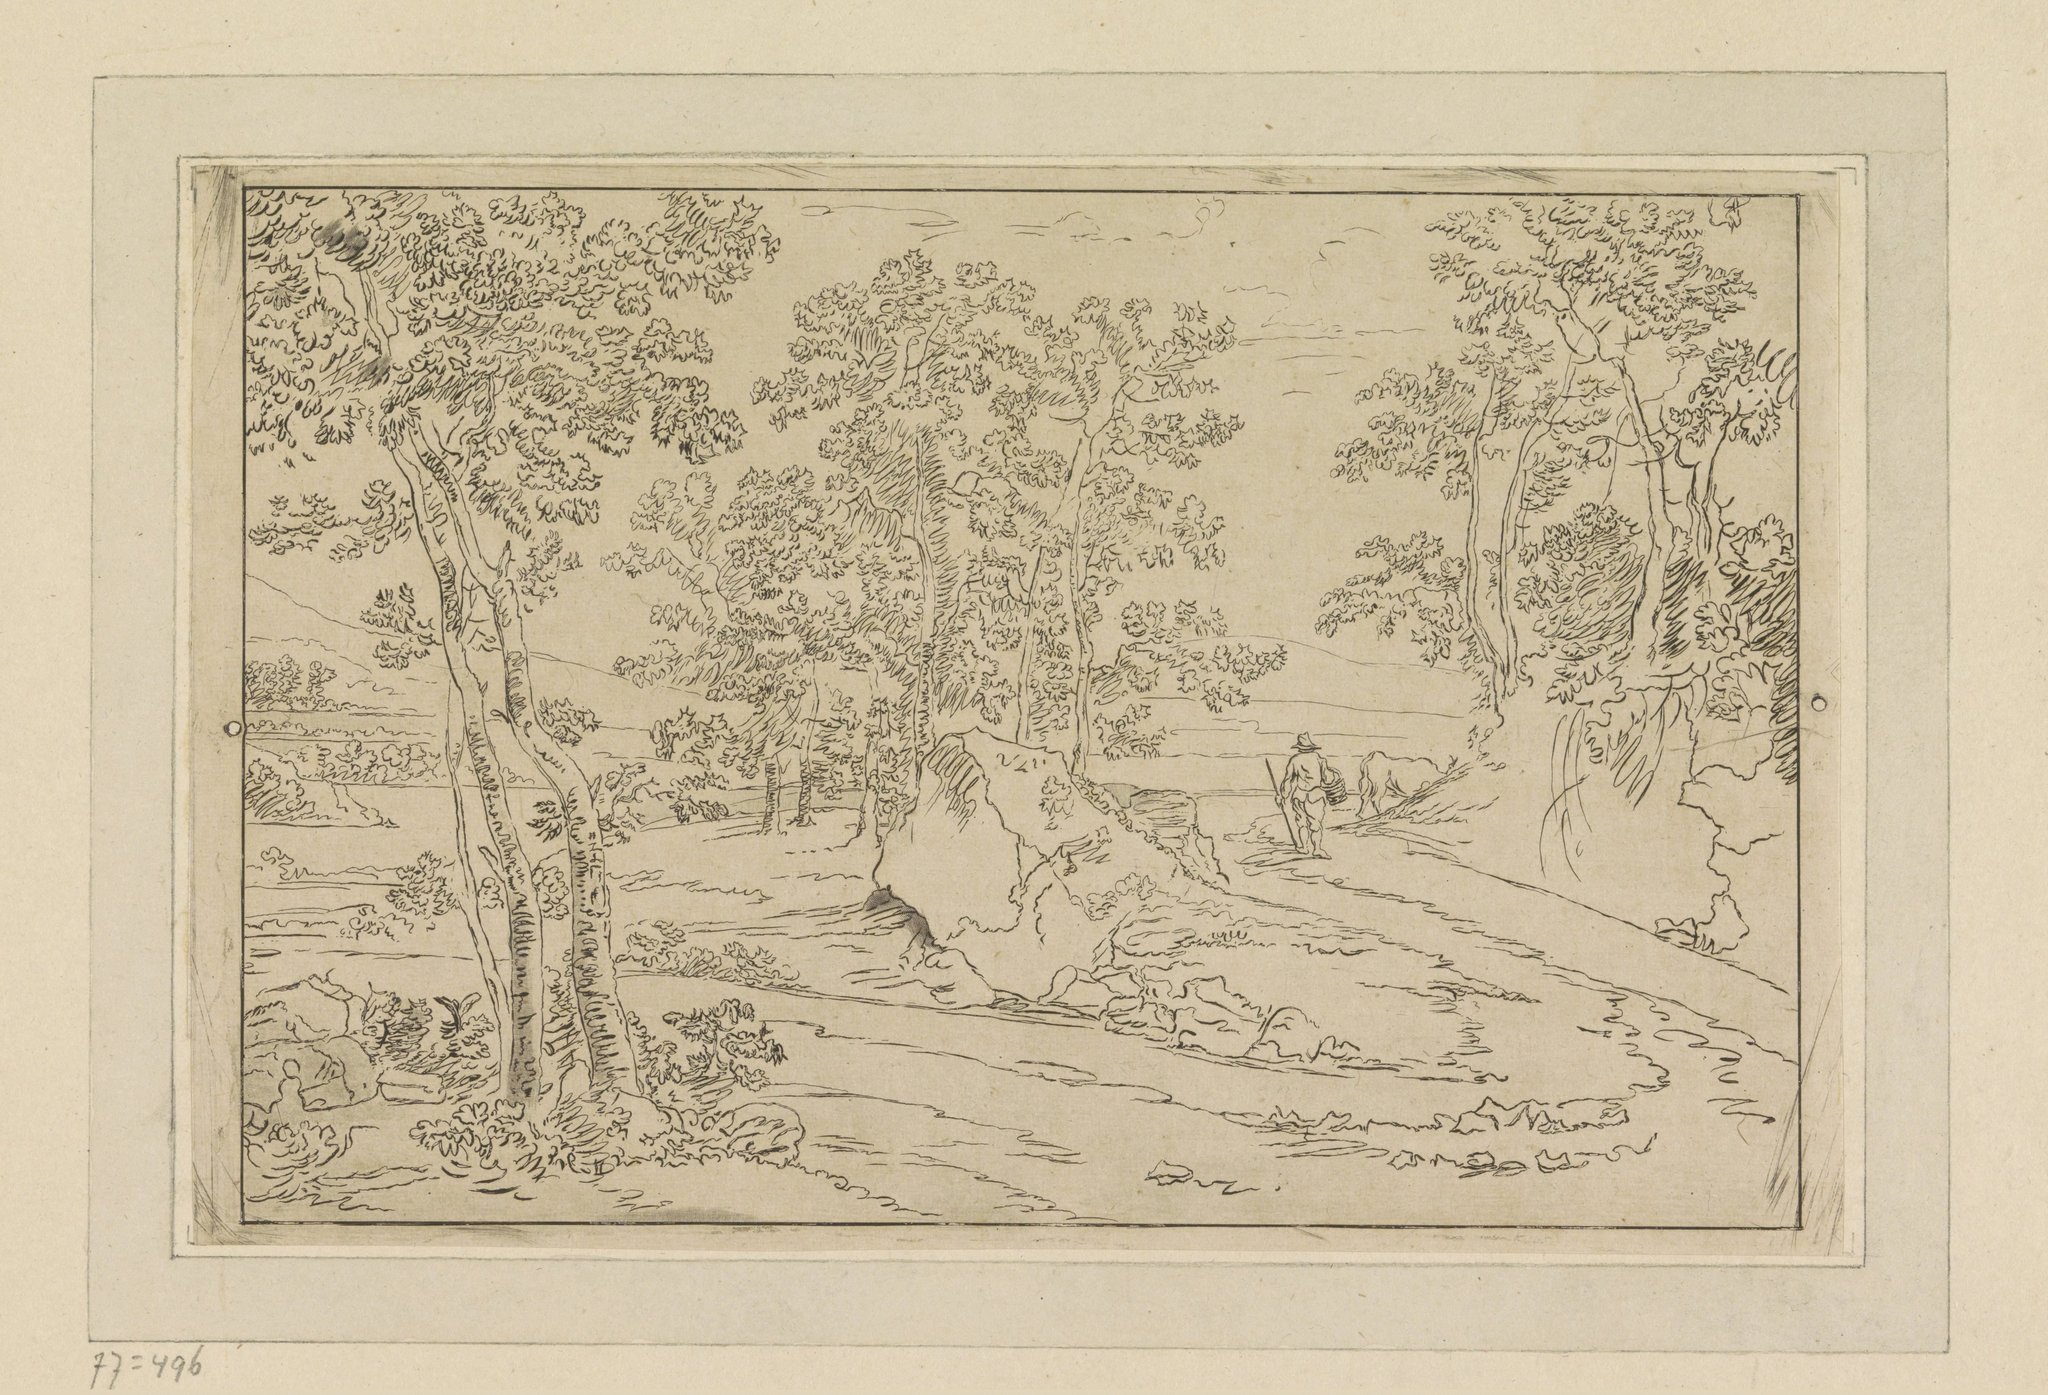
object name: print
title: Boomrijk landschap met veedrijver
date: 1795-1821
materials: paper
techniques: etching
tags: low hill country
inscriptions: collector's mark: Lugt 2228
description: De voltooide prent werd opgenomen in: Collection d'imitations de dessins d'après les principaux maîtres hollandais et flamands, Londen, C. Josi, 1821.